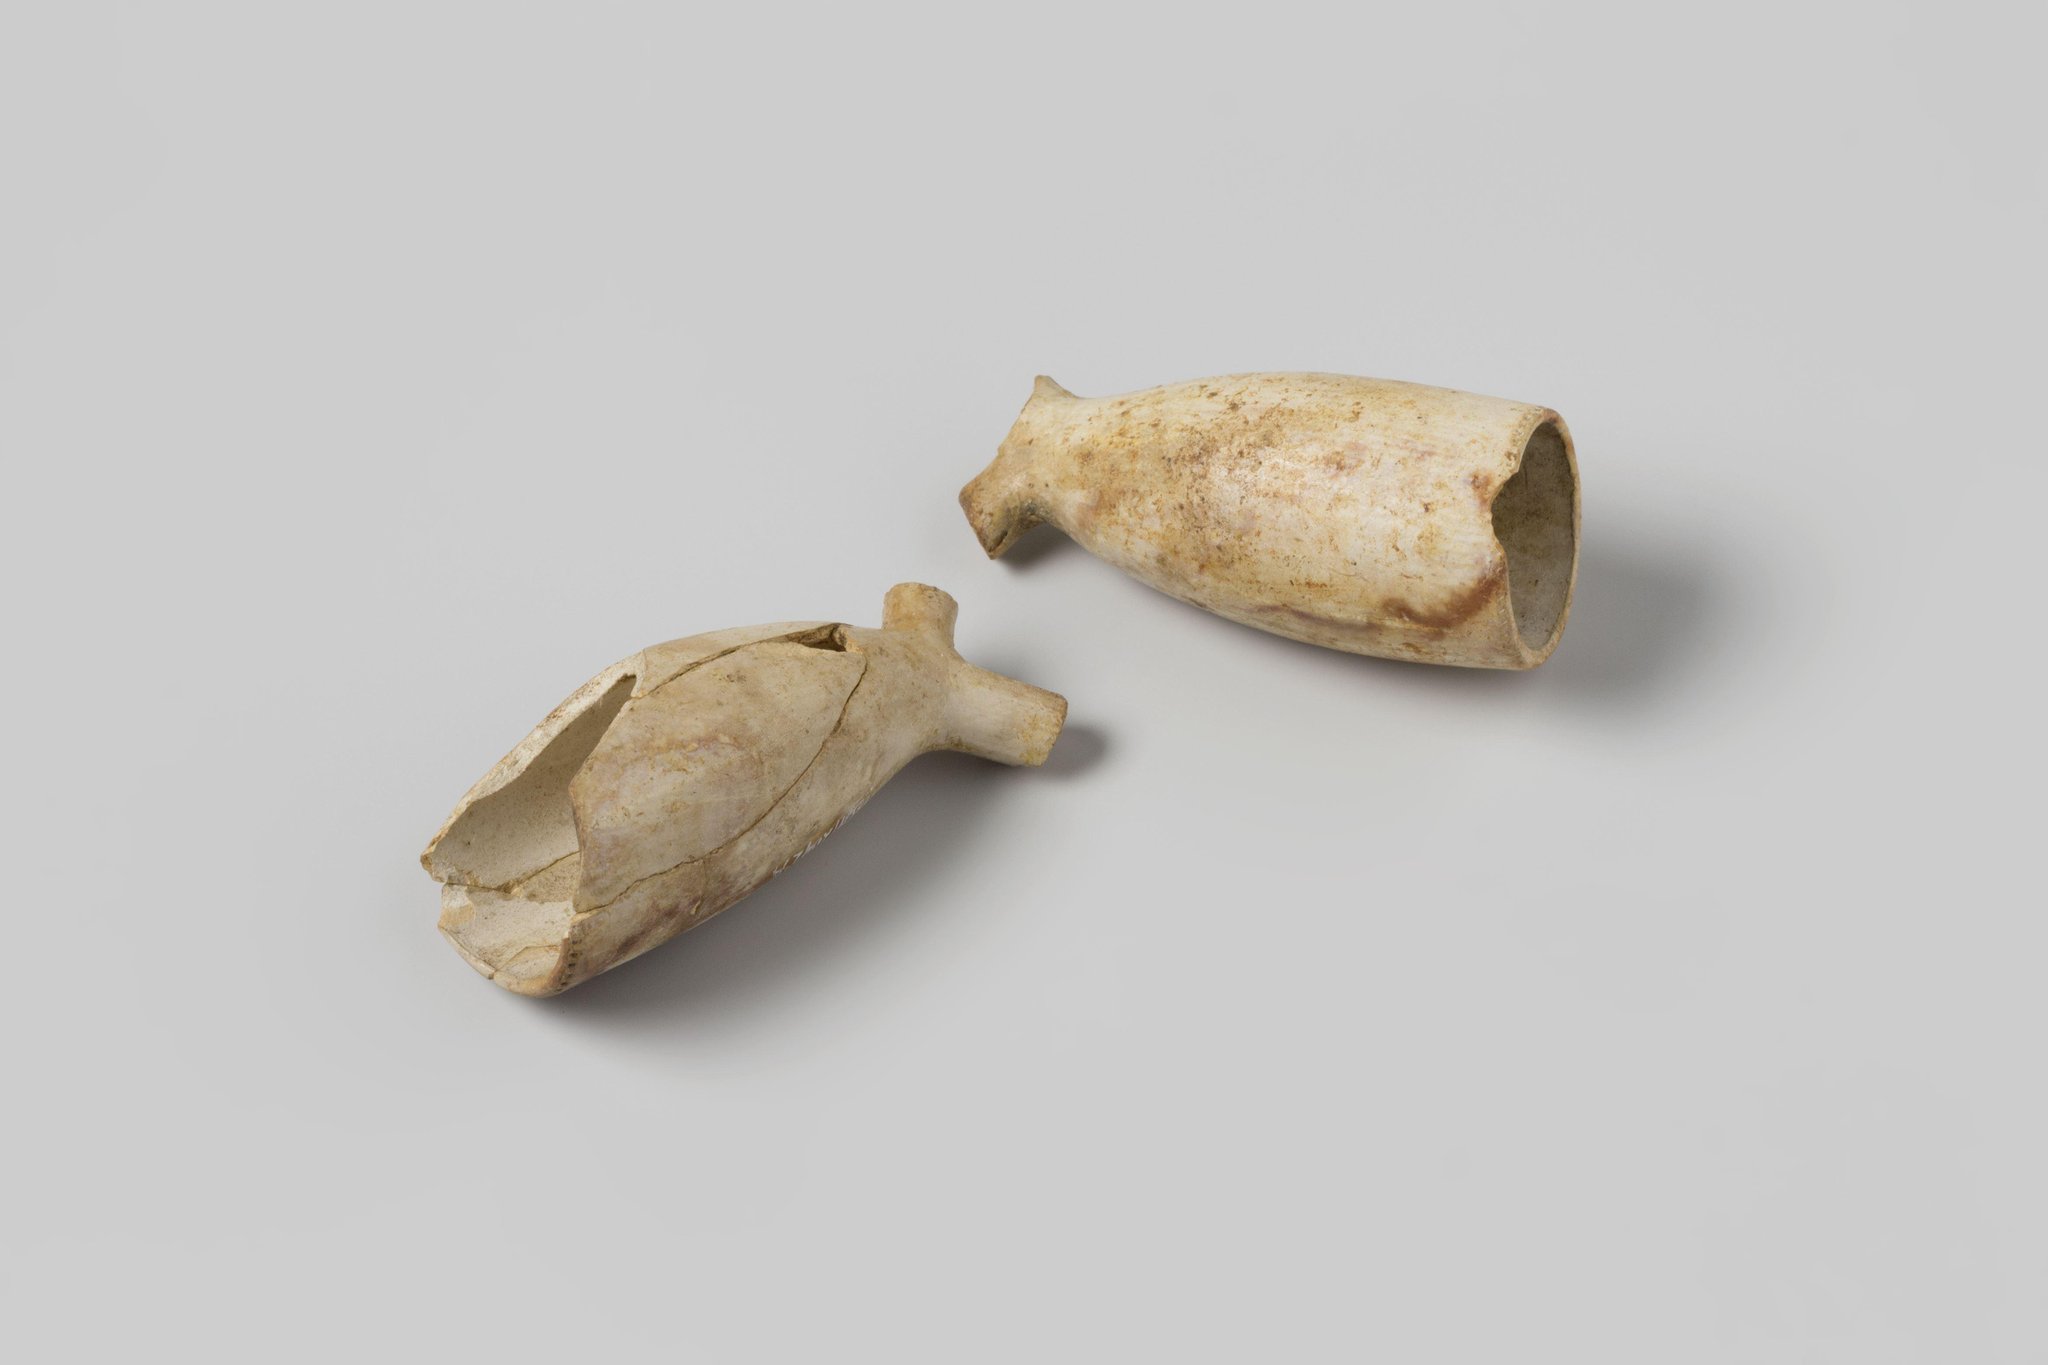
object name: pipe bowl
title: Pijpenkoppen uit het wrak van de Oost-Indiëvaarder Hollandia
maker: Anonymous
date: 1700-1743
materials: clay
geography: netherlands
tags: verenigde oostindische compagnie, hollandia (schip), annet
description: Pipe, bowl, heelmark: coat of arms of the province of Gelderland; fragm, no hsm, 1hsm1.